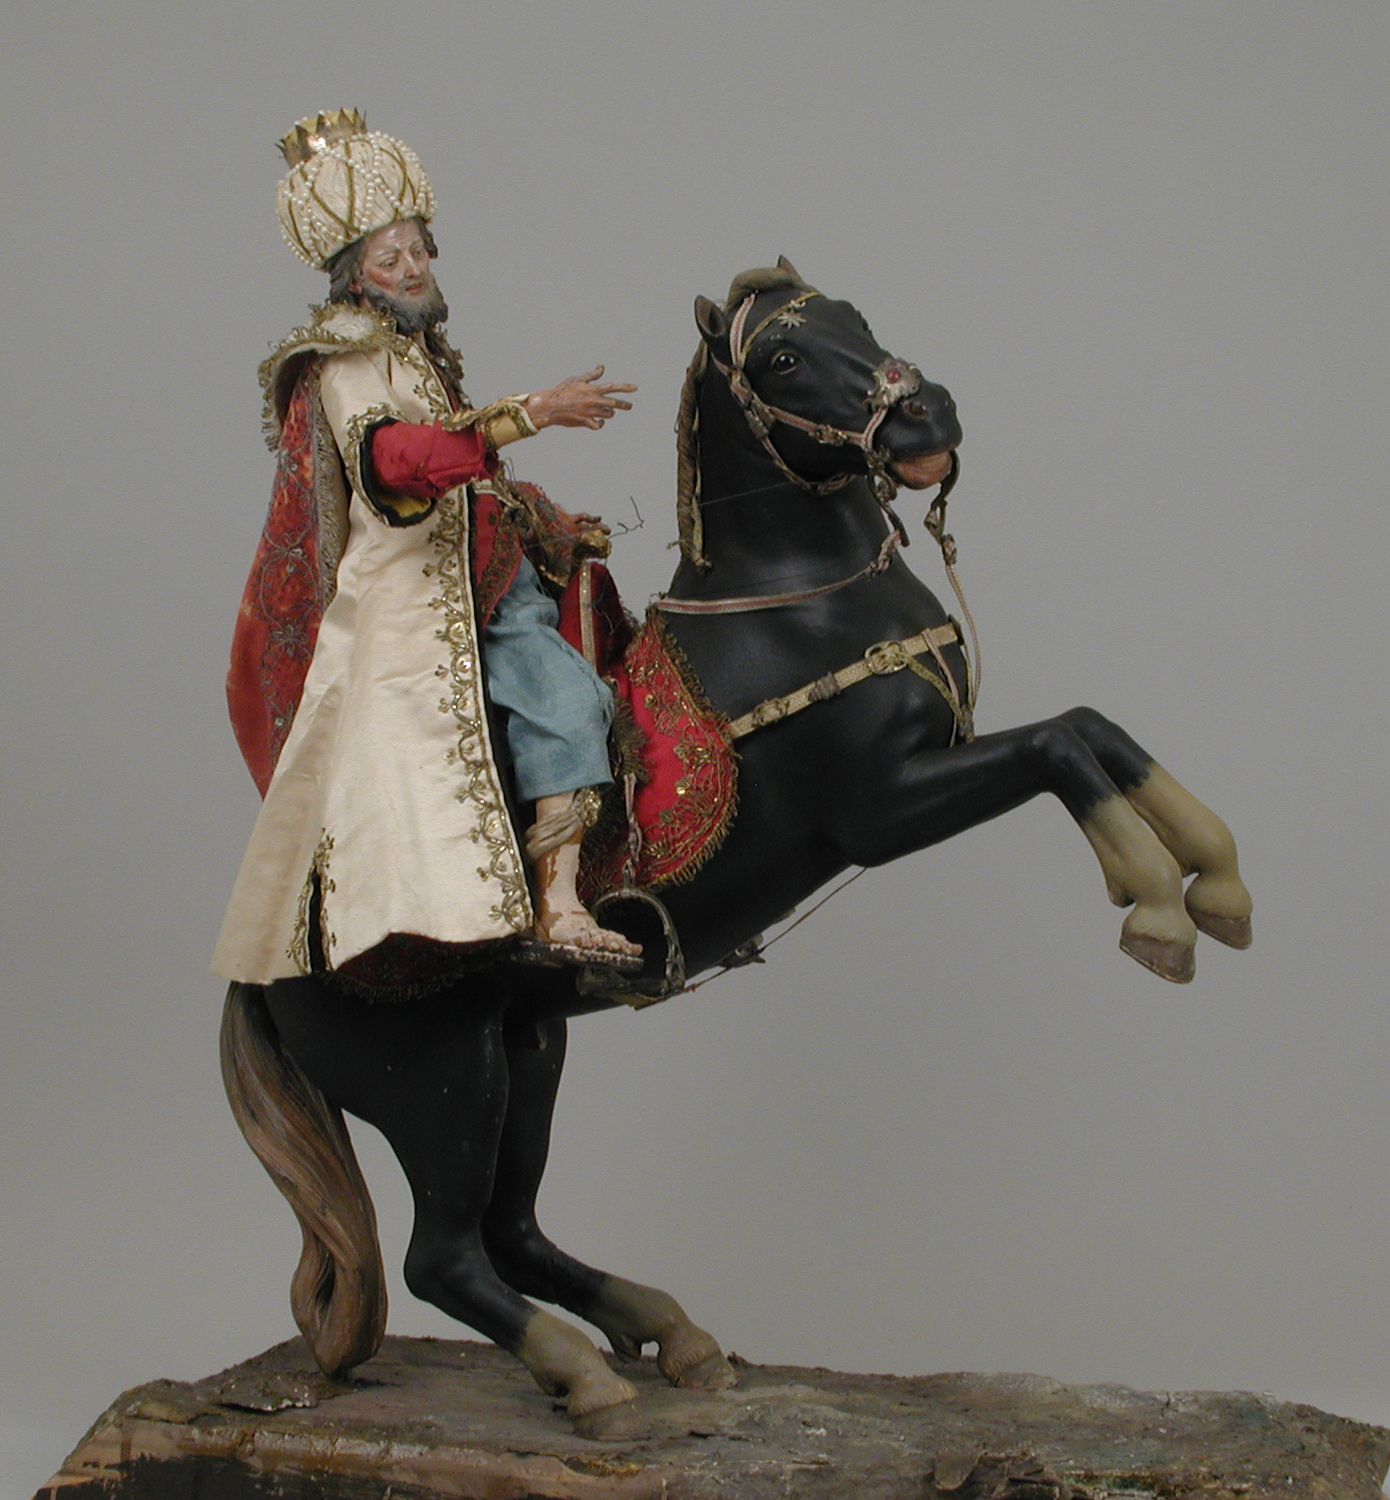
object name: crèche figure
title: Black horse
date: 1751-1800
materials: gold, metal thread, textile, silver, terracotta, velvet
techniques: polychrome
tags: men,horses